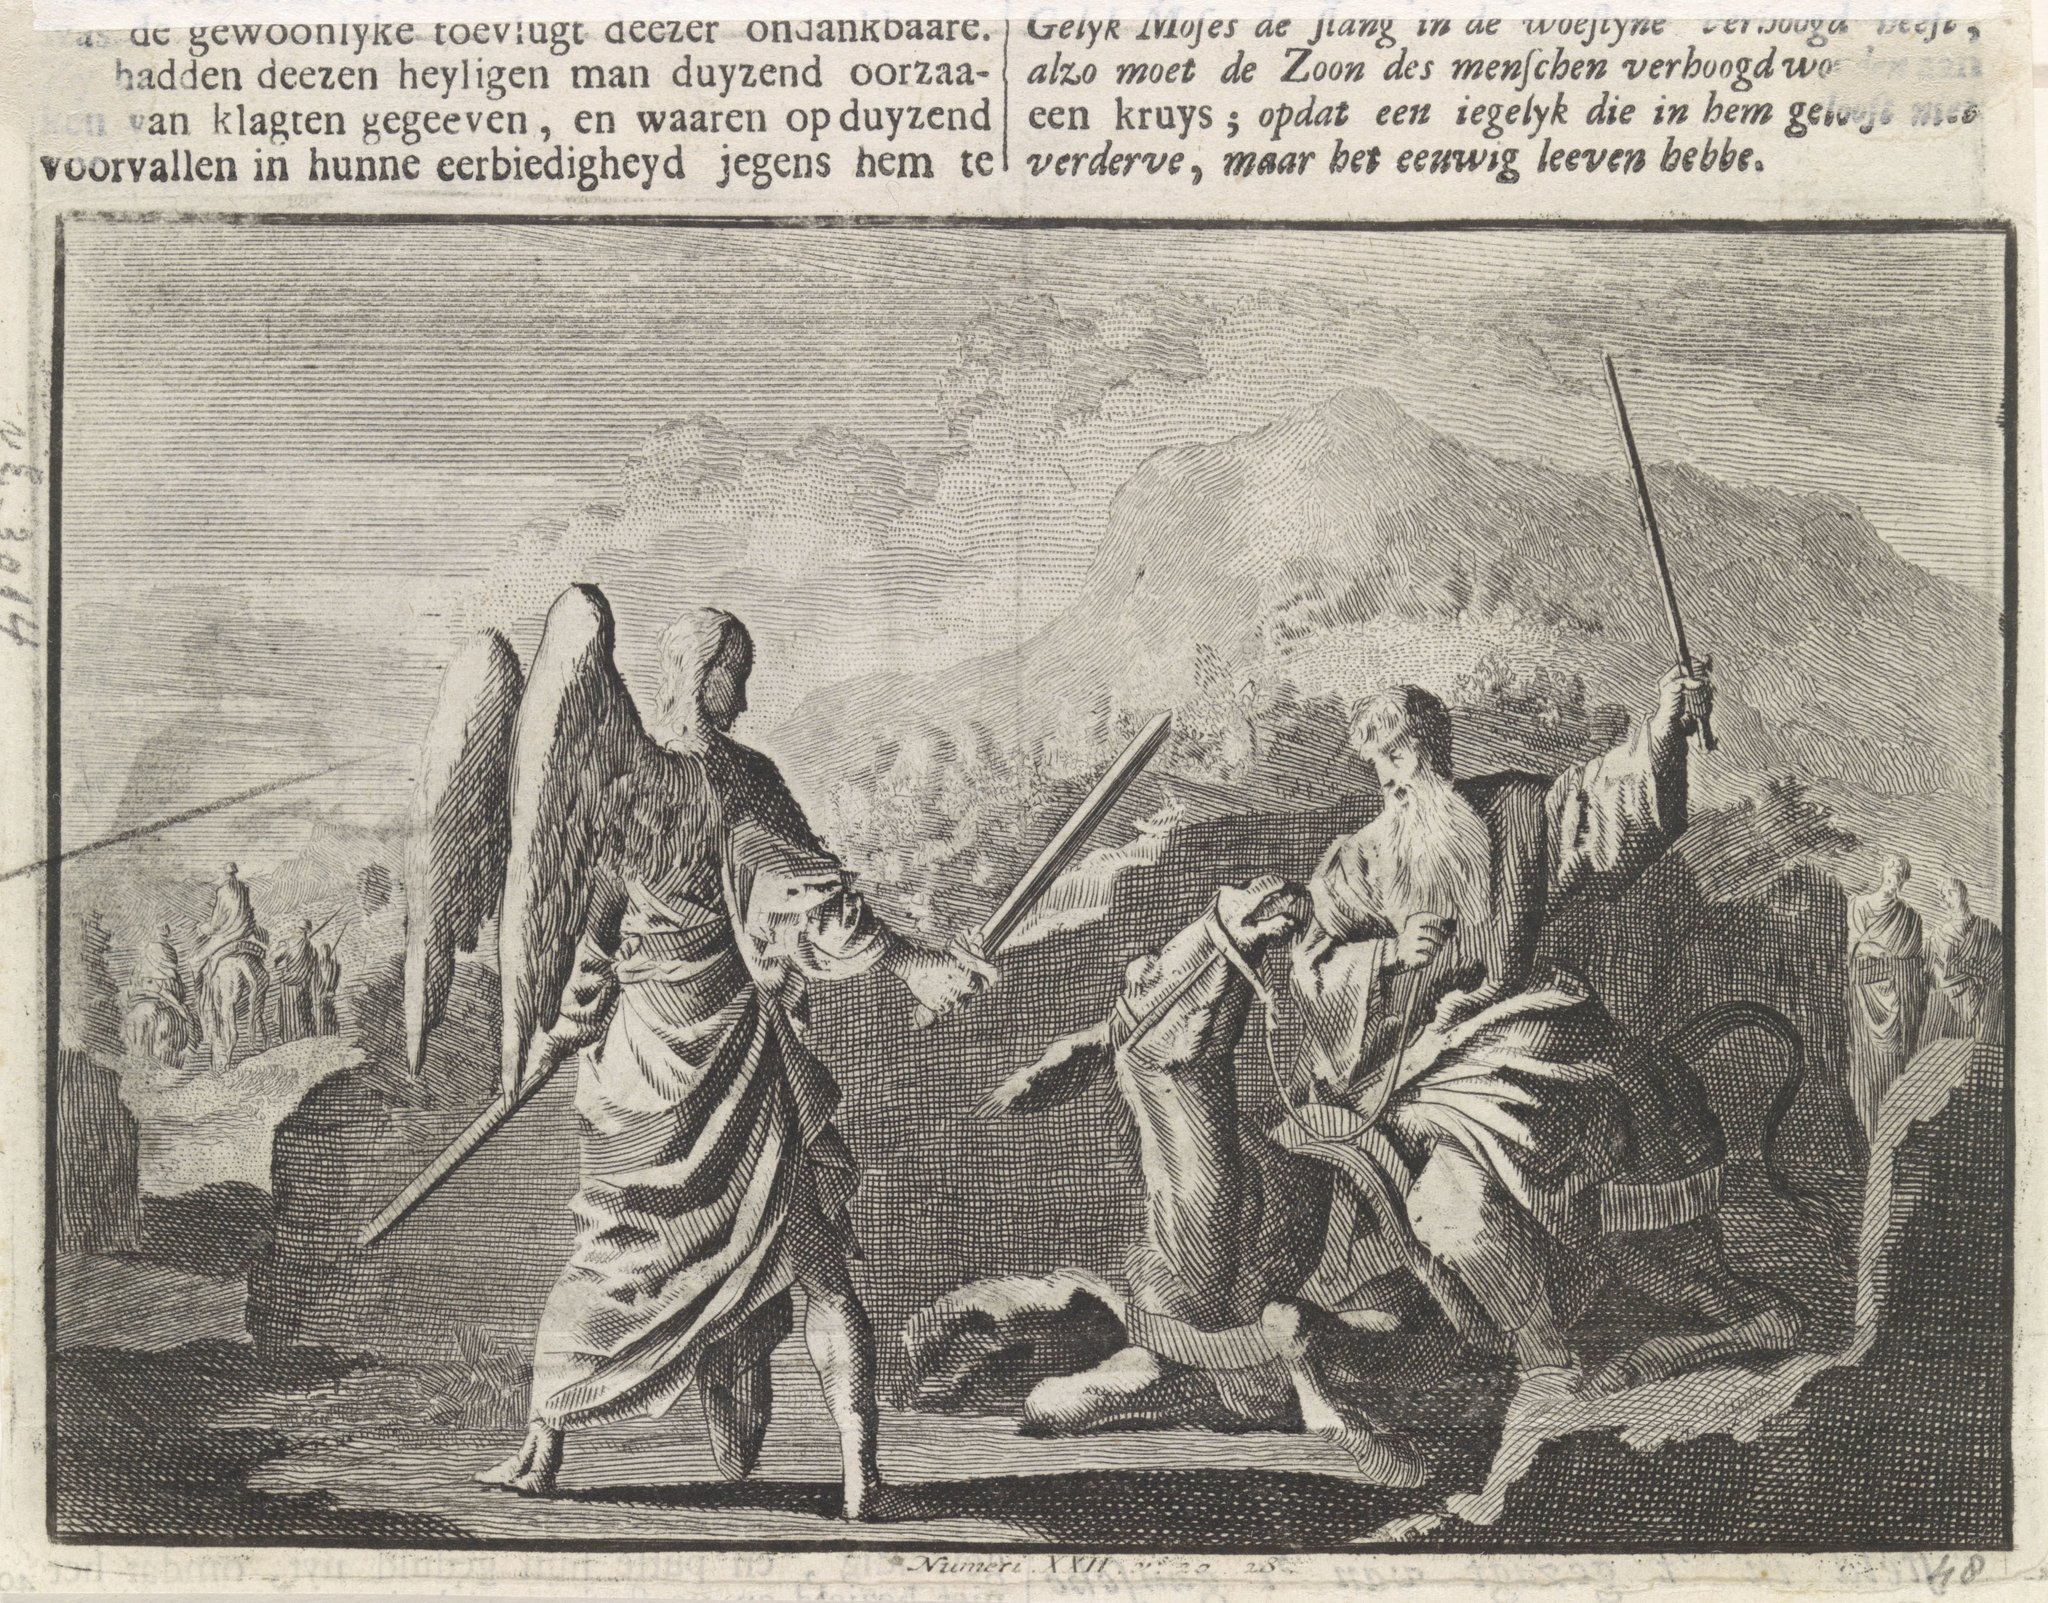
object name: print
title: Bileam (Balaäm) en de engel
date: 1703-1762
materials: paper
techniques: etching, letterpress printing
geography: haarlem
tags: balaam strikes his ass, whereupon the ass lies down and starts to speak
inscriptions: collector's mark: Lugt 2228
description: De prent komt een eerste keer voor als boekillustratie voor David Martin. Historie des Ouden en Nieuwen Testaments. Amsterdam, Pieter Mortier, 1703. Deel I. De boekillustraties voor de Mortierbijbel hebben verschillende staten en kopieën, waarbij de chronologische volgorde moeilijk te achterhalen valt. Als boekillustraties werden ze bovendien herhaaldelijk opnieuw gebruikt voor andere boekwerken.